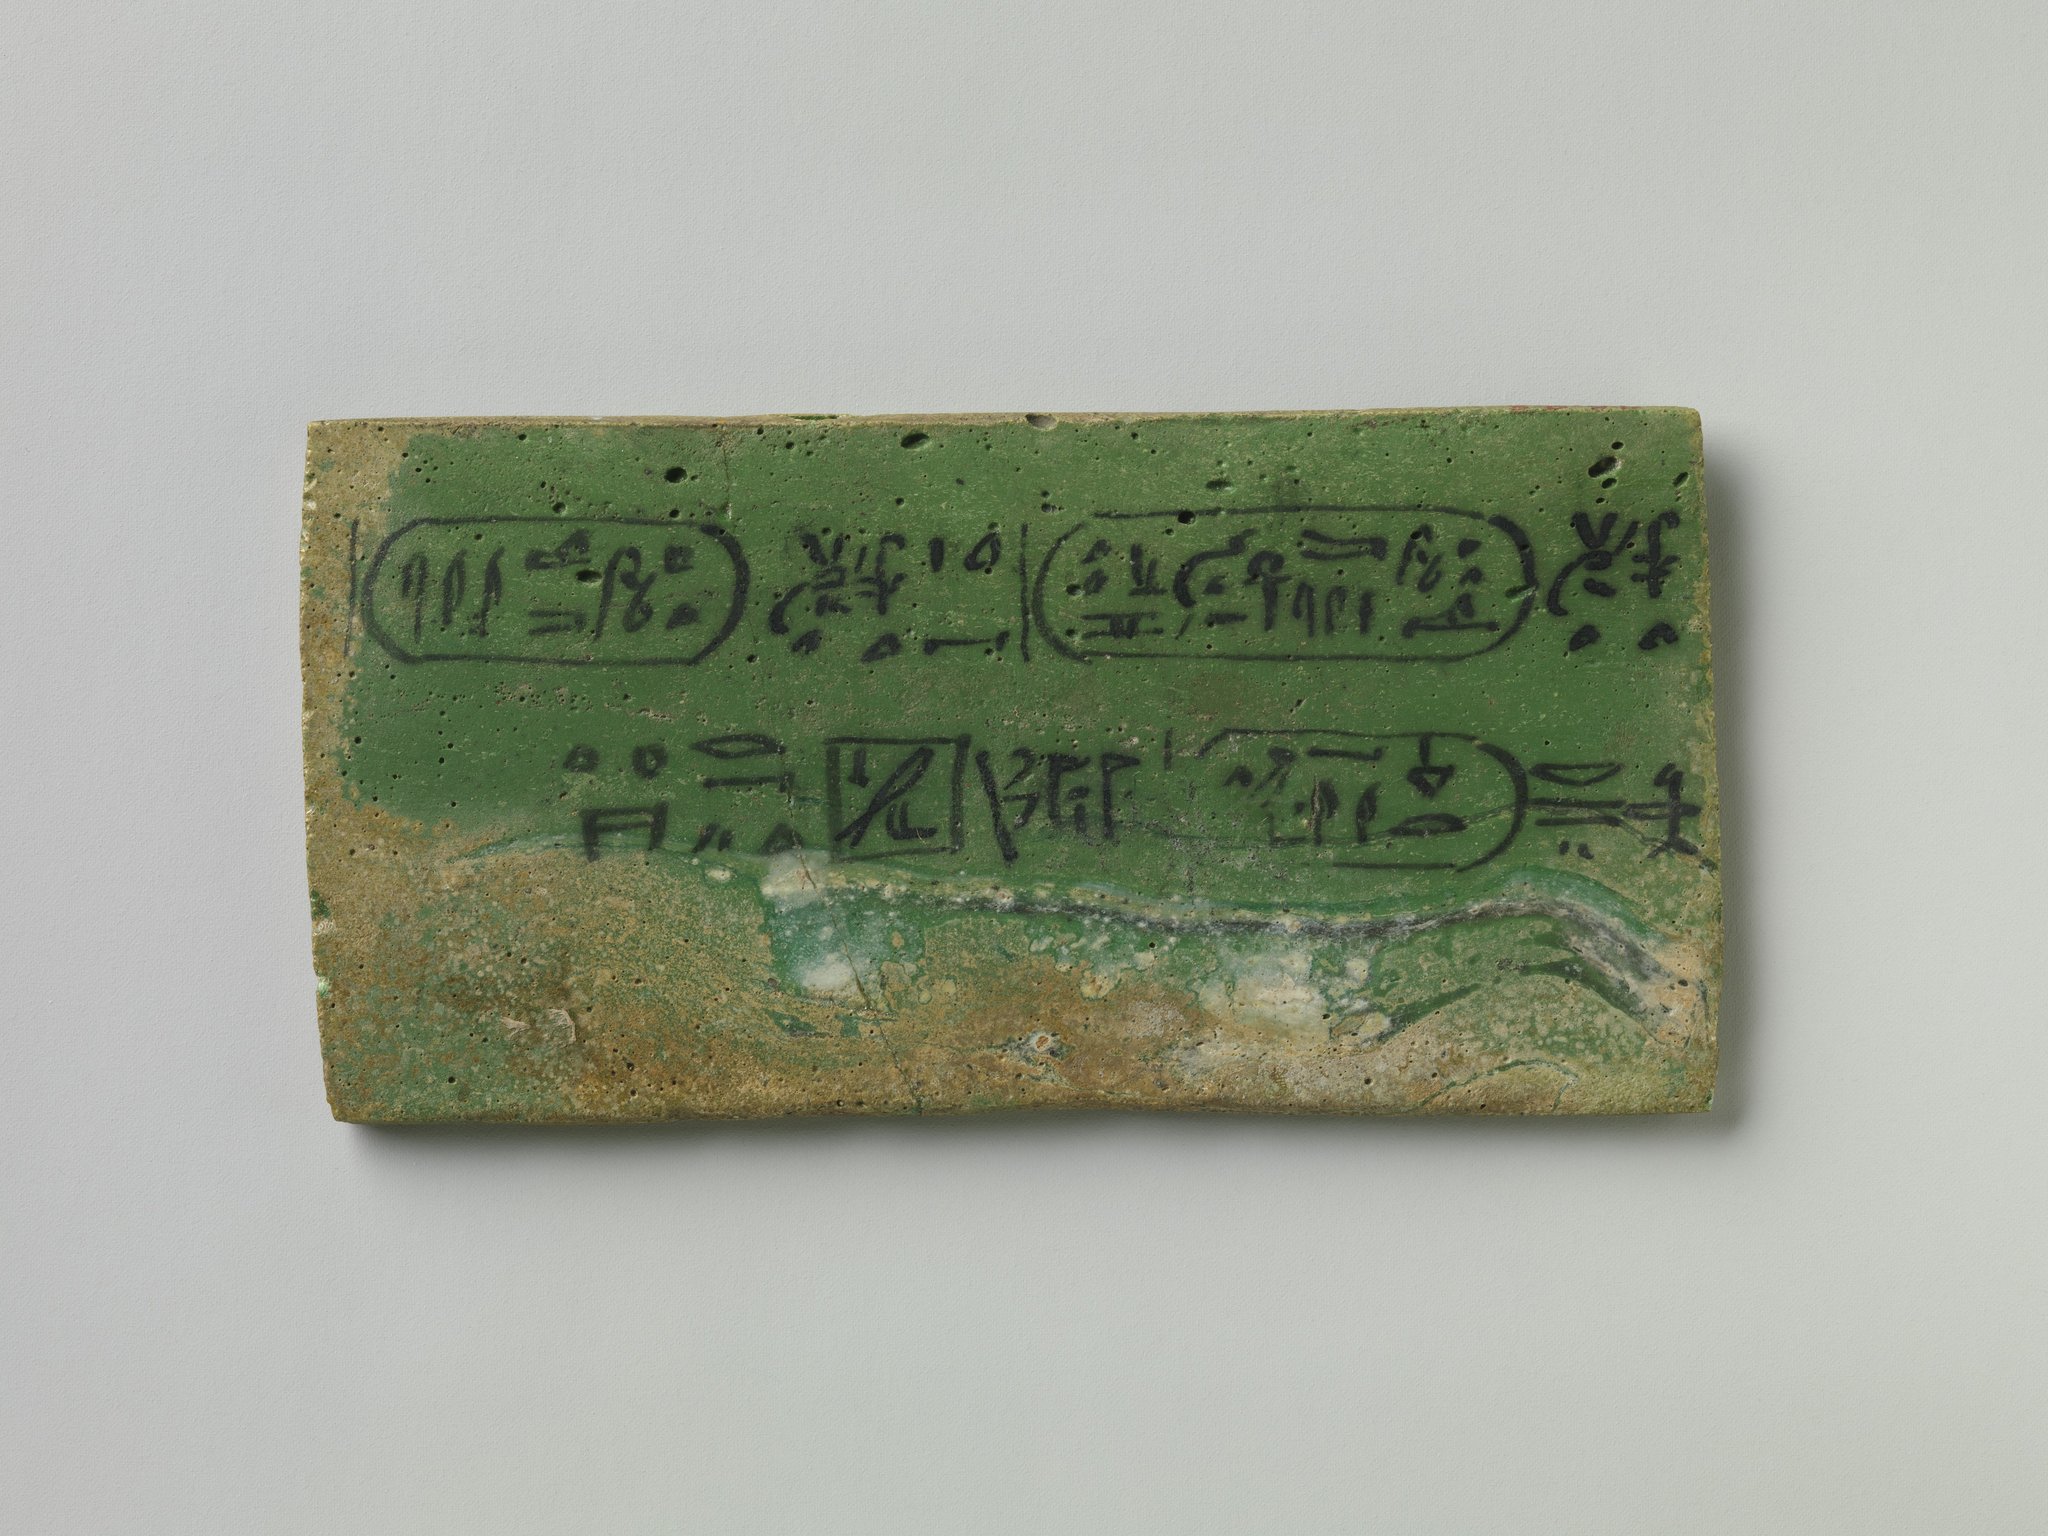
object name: plaque, hathor, aphrodite, foundation deposit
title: Foundation plaque for a temple dedicated to Hathor / Aphrodite at Cusae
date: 222-204 BCE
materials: glass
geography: egypt